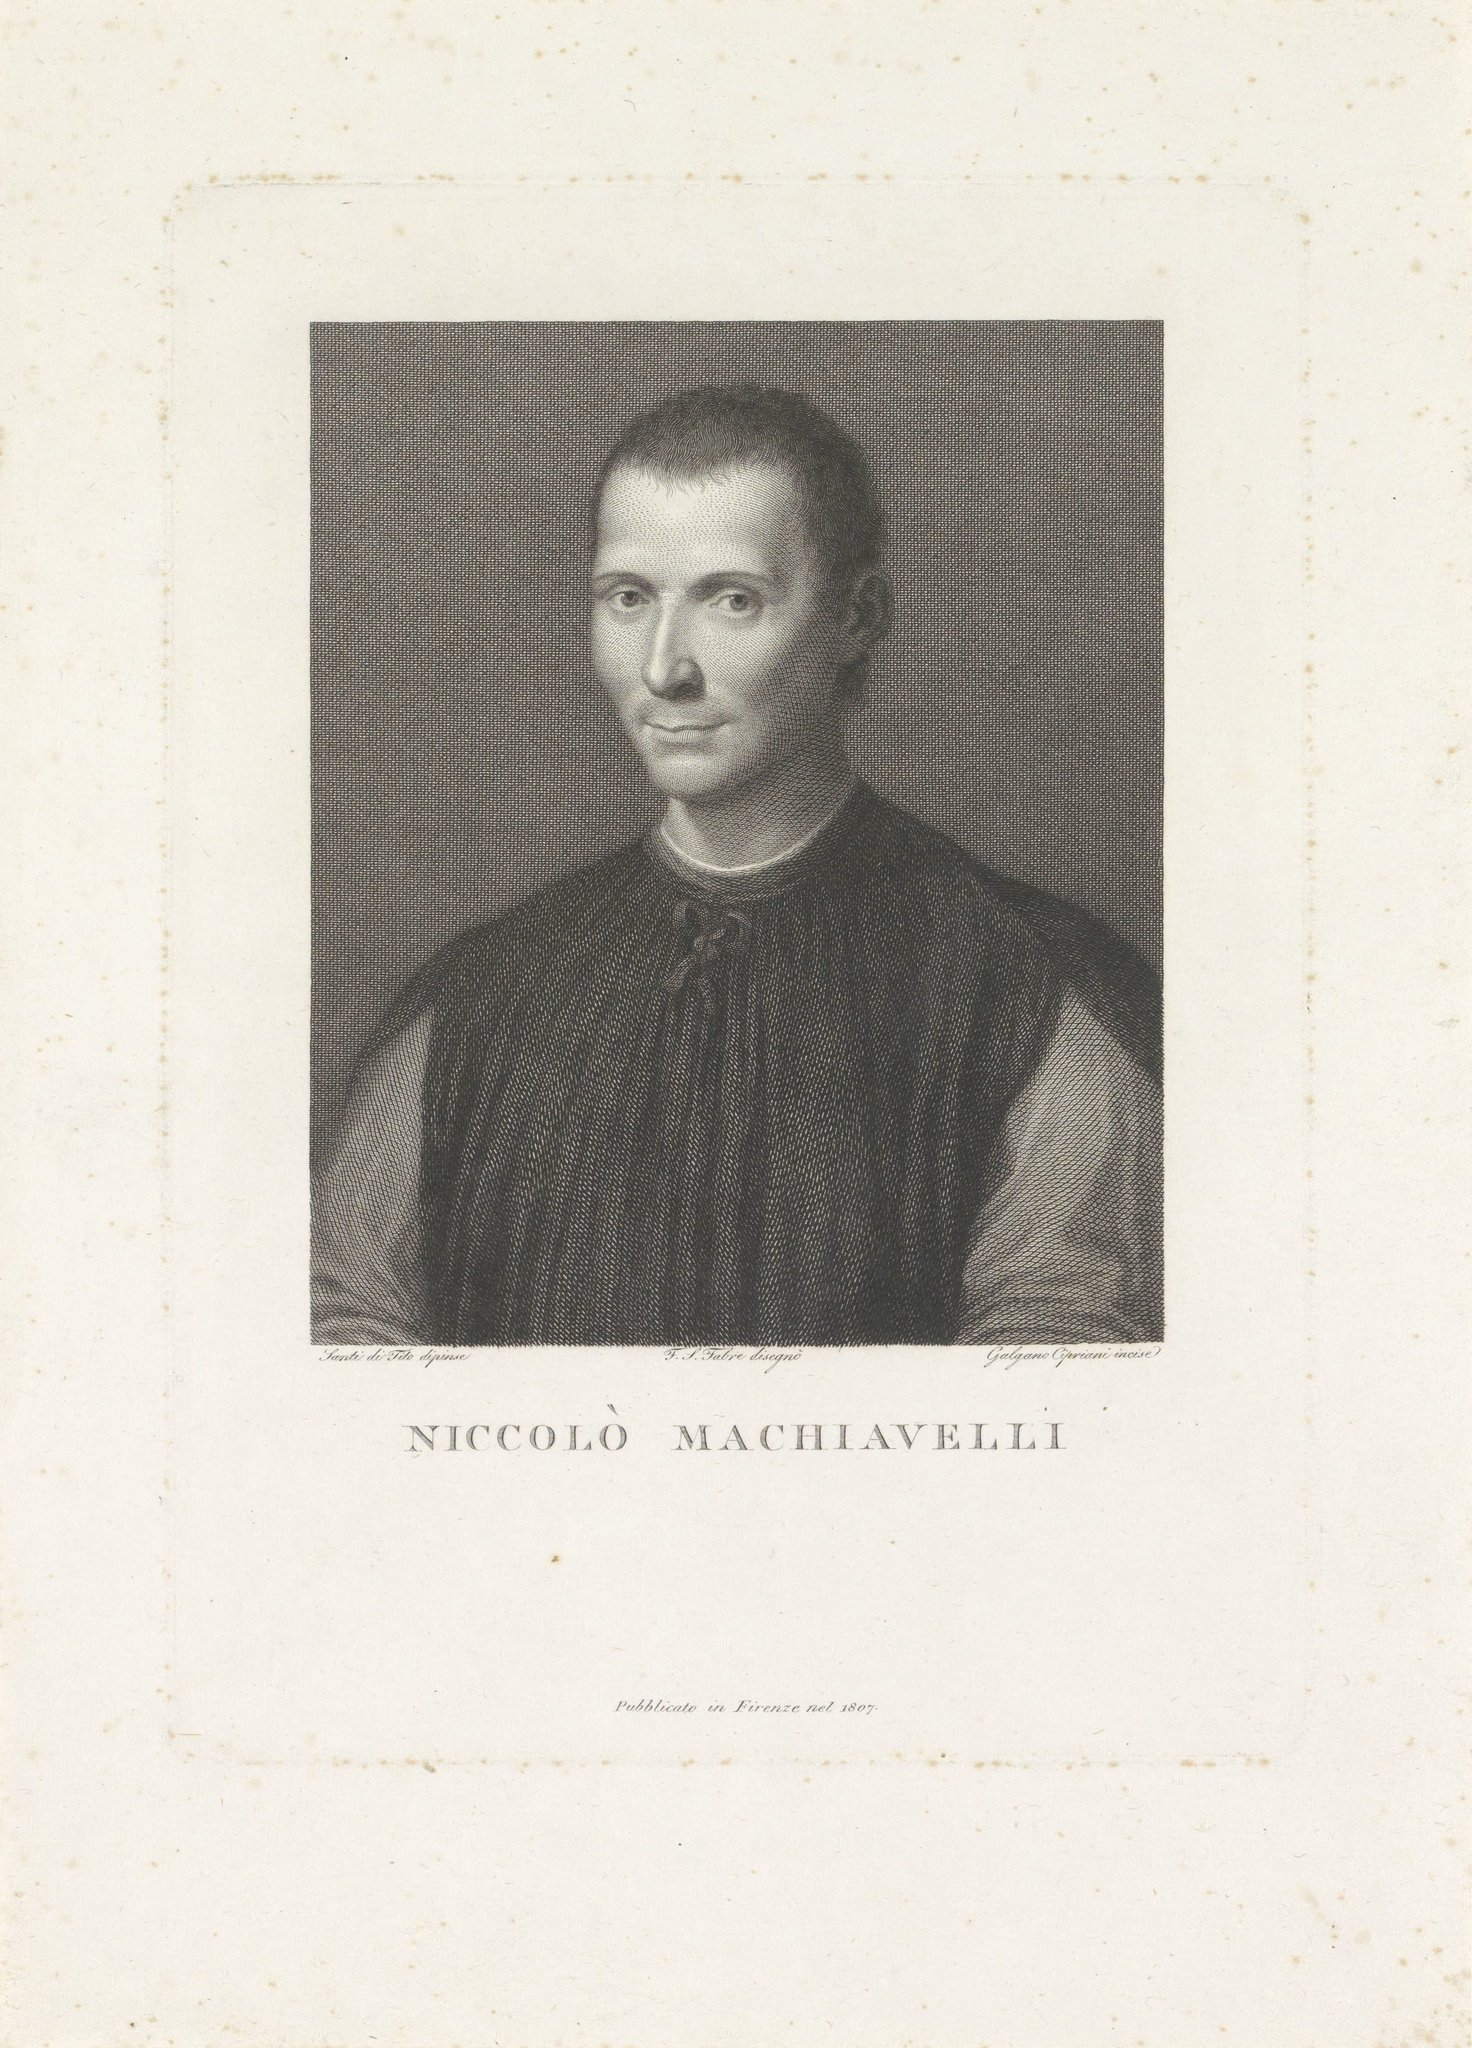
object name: print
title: Portret van Niccolò Machiavelli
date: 1807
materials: paper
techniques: engraving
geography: italy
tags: historical persons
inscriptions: collector's mark: Lugt 12, collector's mark: Lugt 2165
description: Naar een schilderij door Santi di Tito in Palazzo Vecchio te Florence.